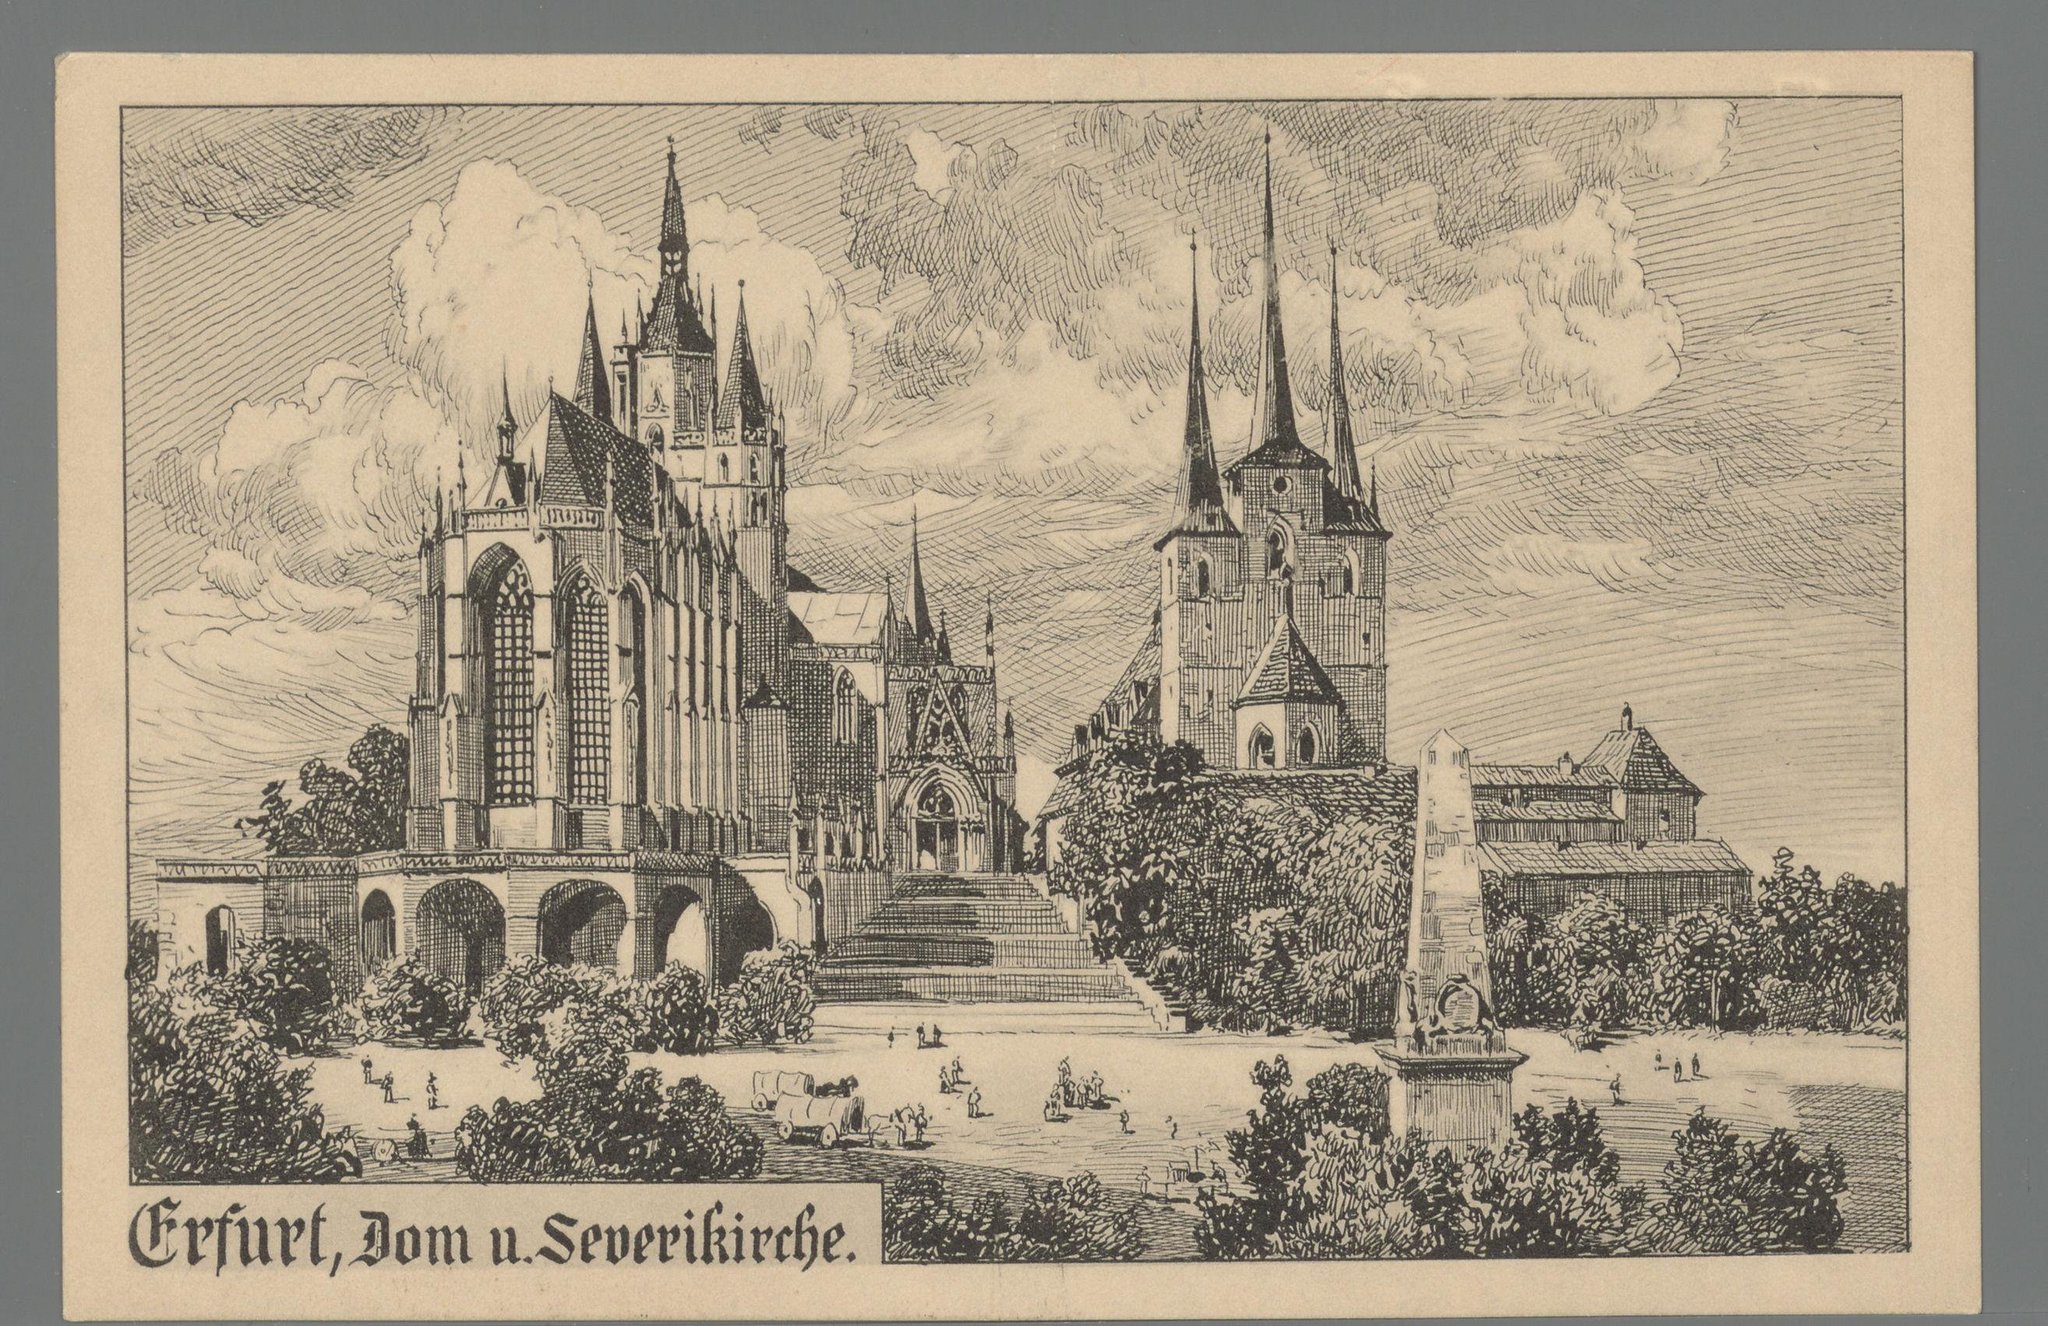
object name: ansichtkaart, prentbriefkaart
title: Erfurt, Dom u. Severikirche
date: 1913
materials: cardboard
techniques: photograph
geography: gotha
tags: obelisk, needle, church (exterior)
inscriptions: date